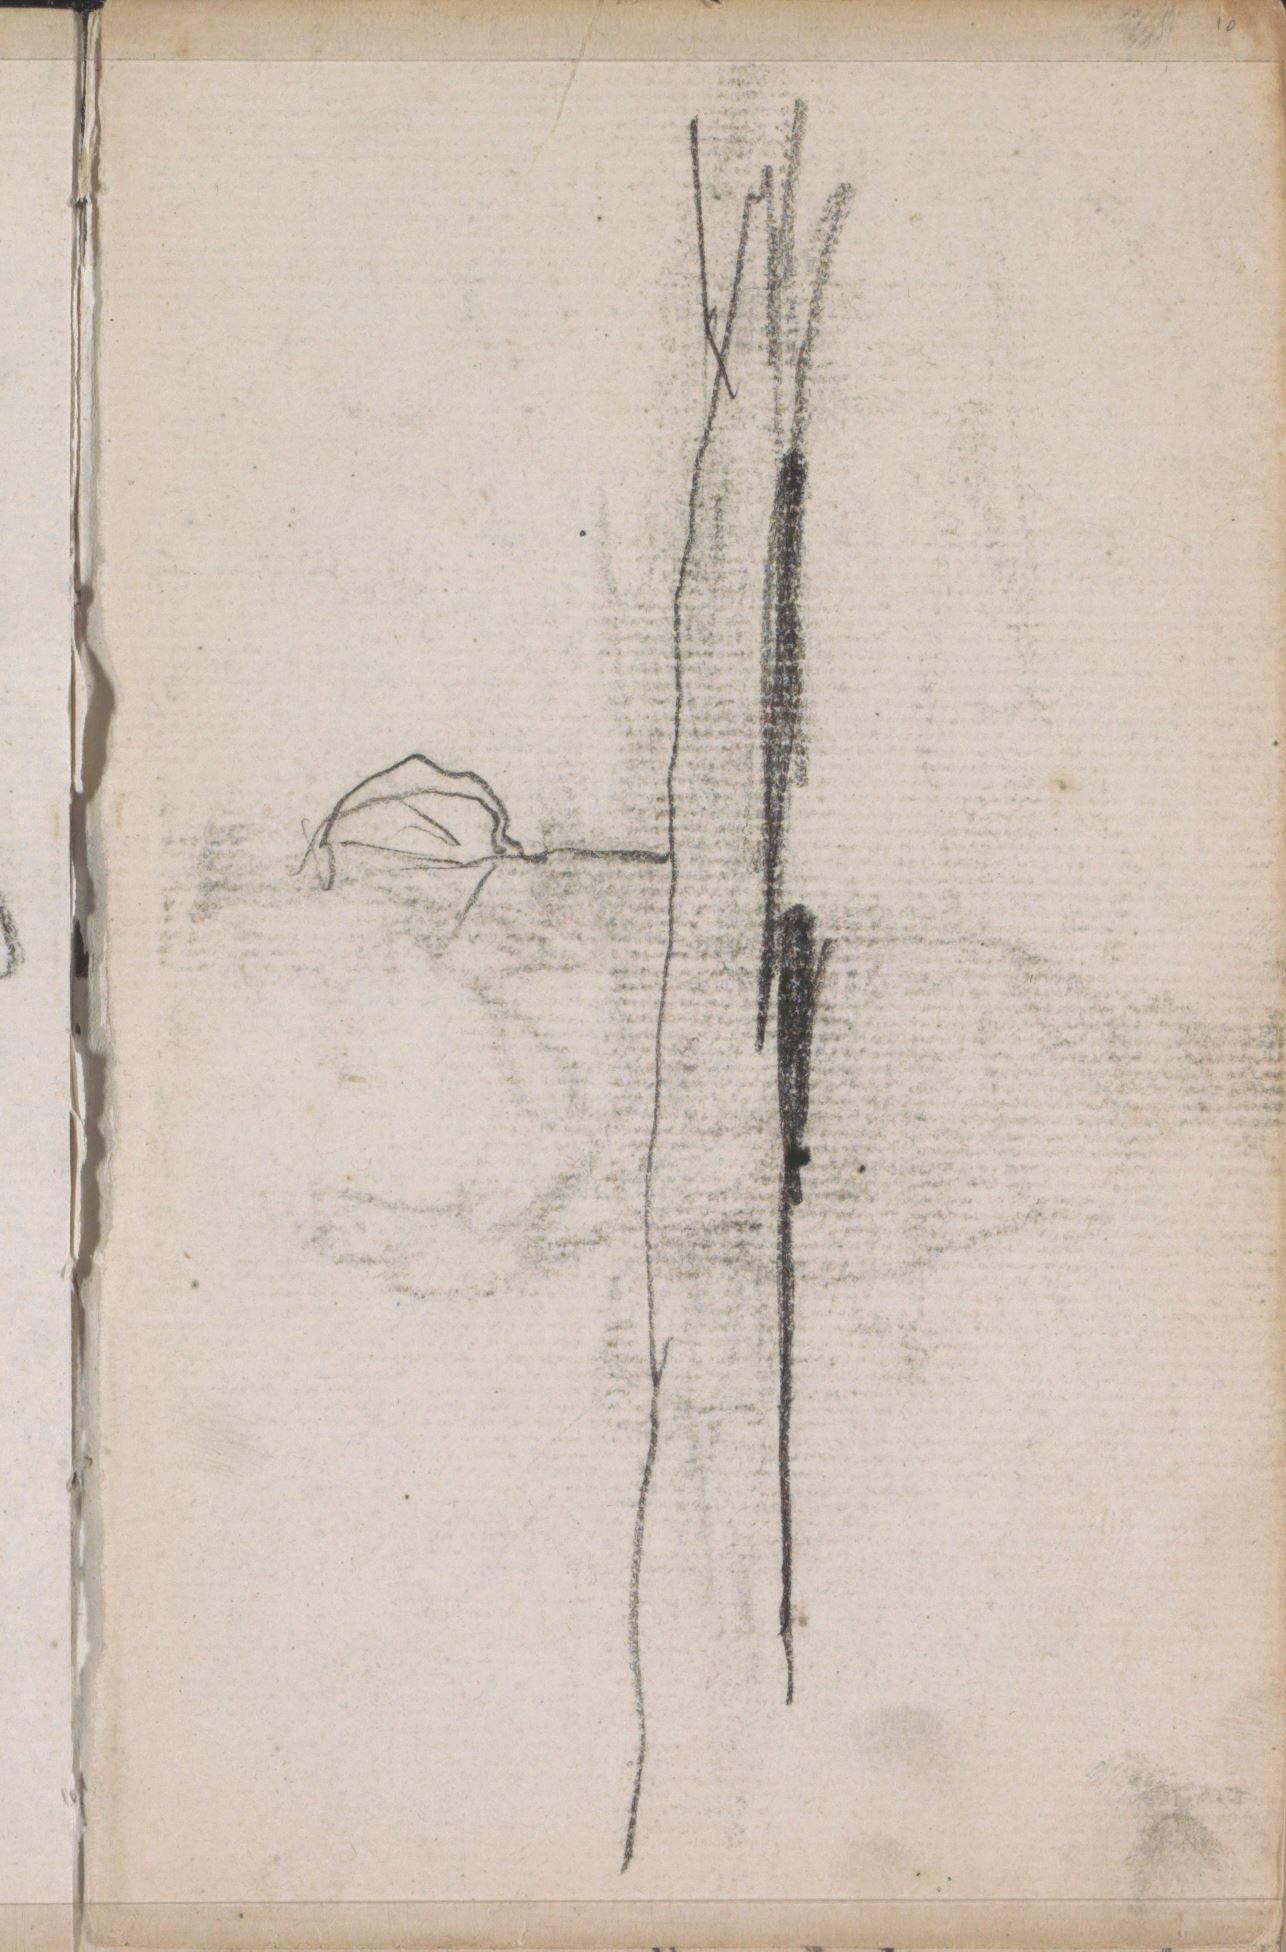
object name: sketchbook leaf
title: Landschap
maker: george hendrik breitner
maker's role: draughtsman, painter, print maker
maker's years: 1857-1923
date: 1884-1886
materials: chalk, paper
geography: drenthe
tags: landscapes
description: Pagina 10 uit een schetsboek met 67 bladen vervaardigd in Drenthe.